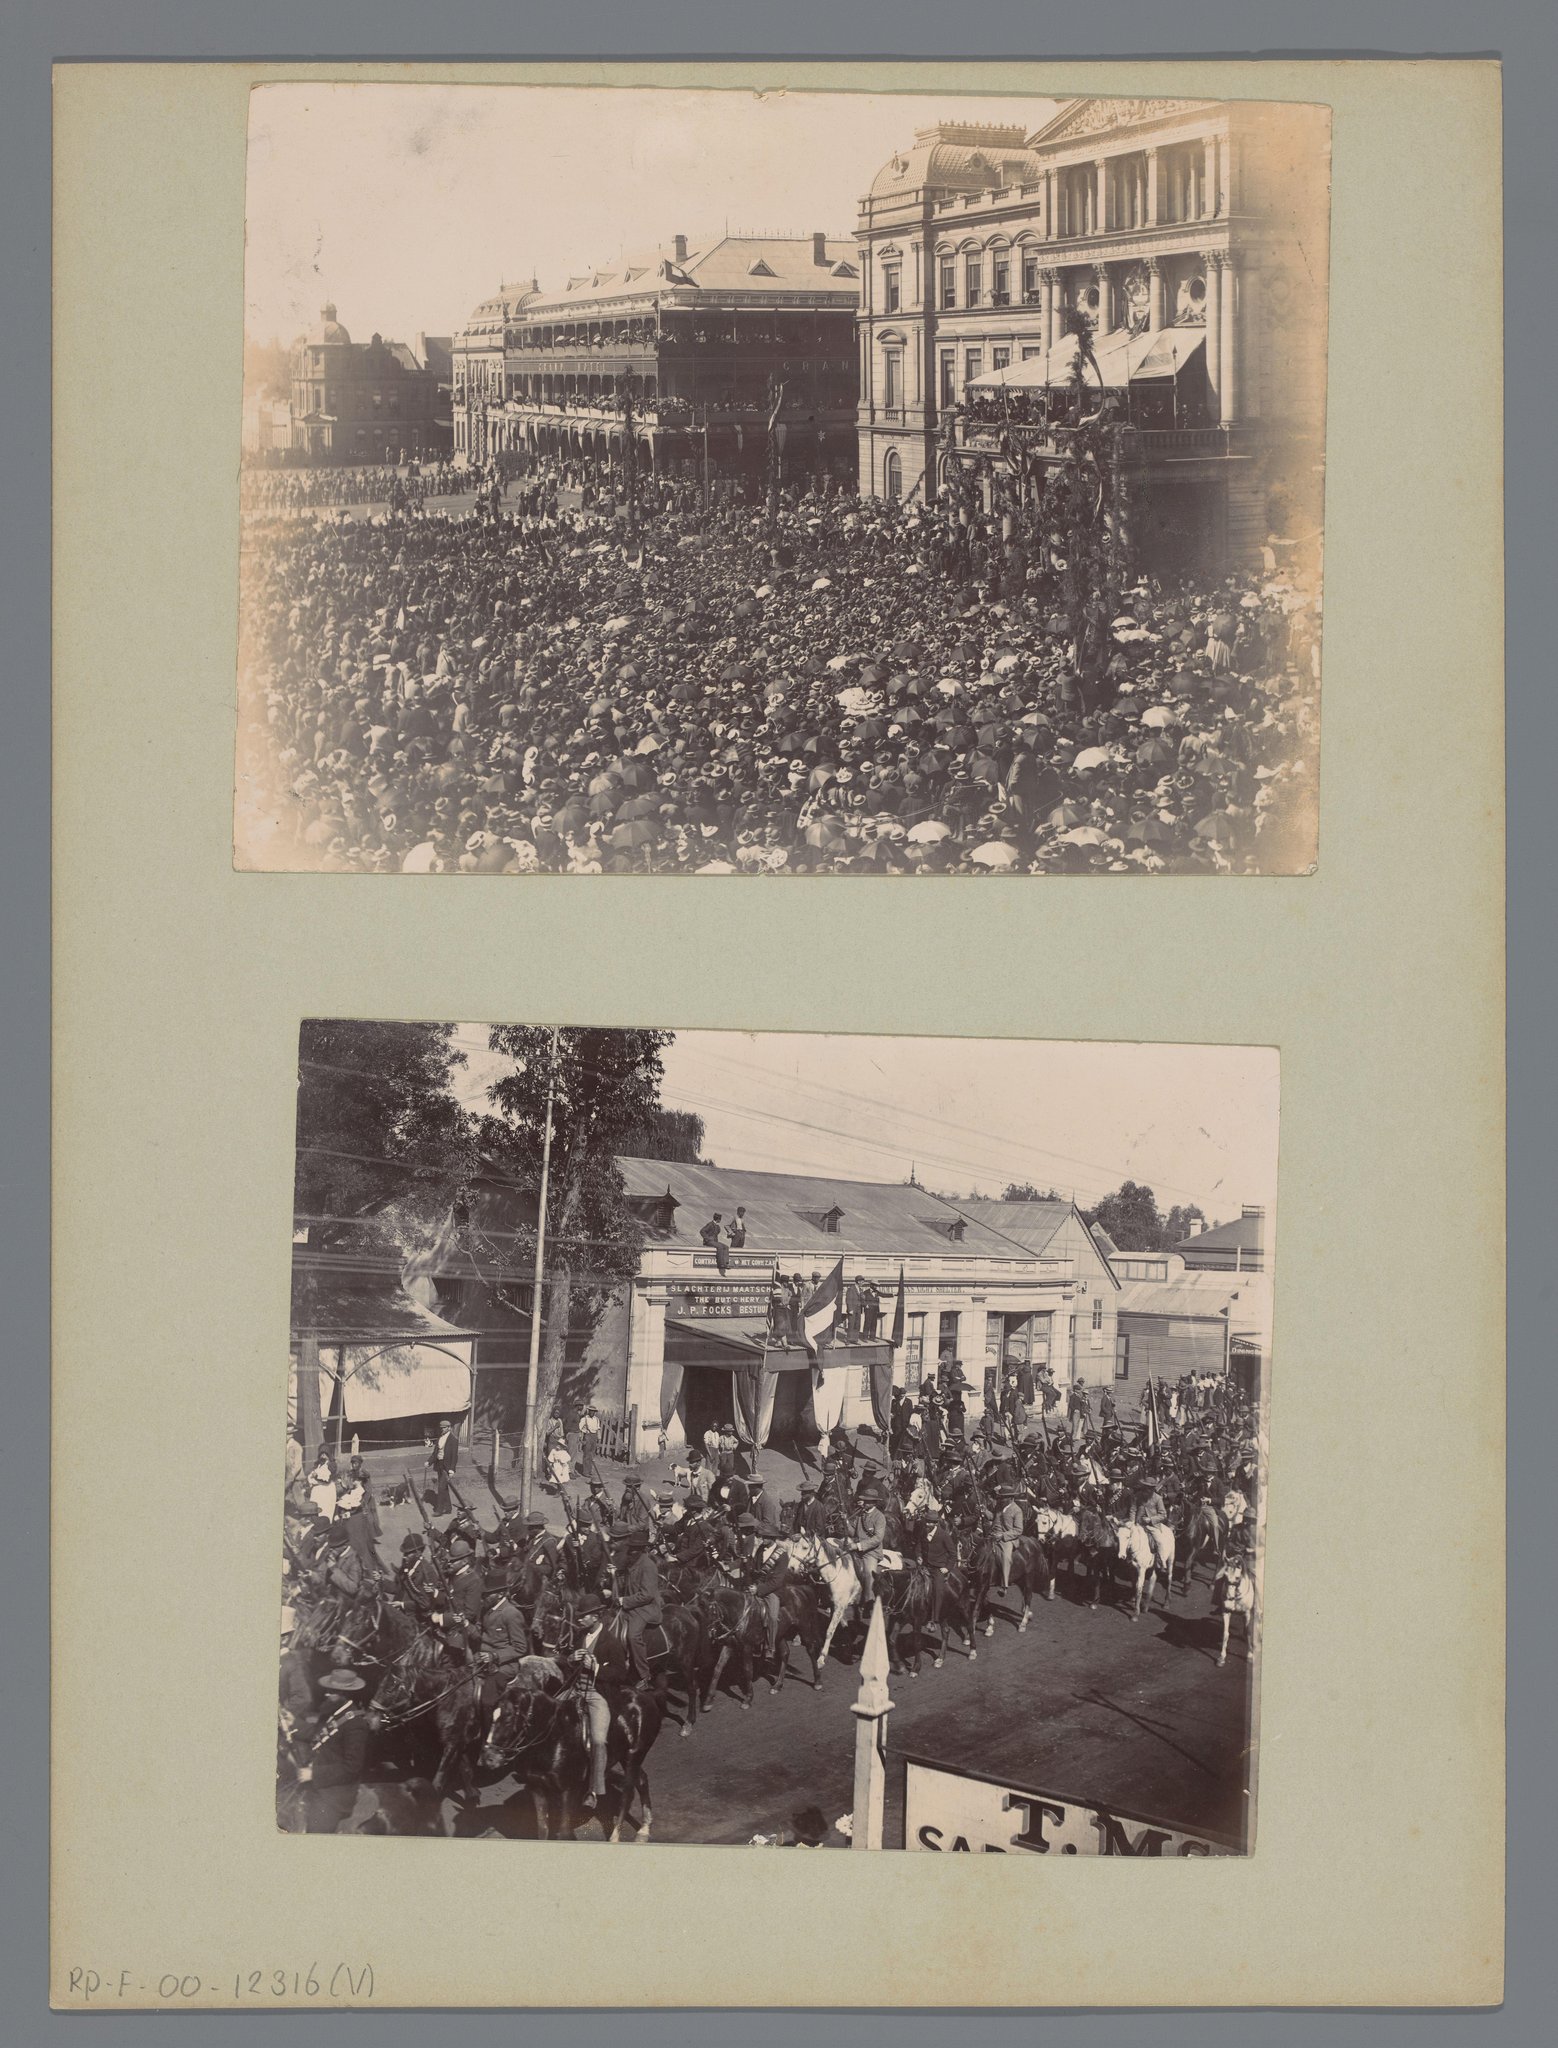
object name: blad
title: Blad met twee foto's van Pretoria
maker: Anonymous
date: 1890-1905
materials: paper, cardboard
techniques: gelatin silver print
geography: pretoria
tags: ceremonial celebration of installation of a ruler